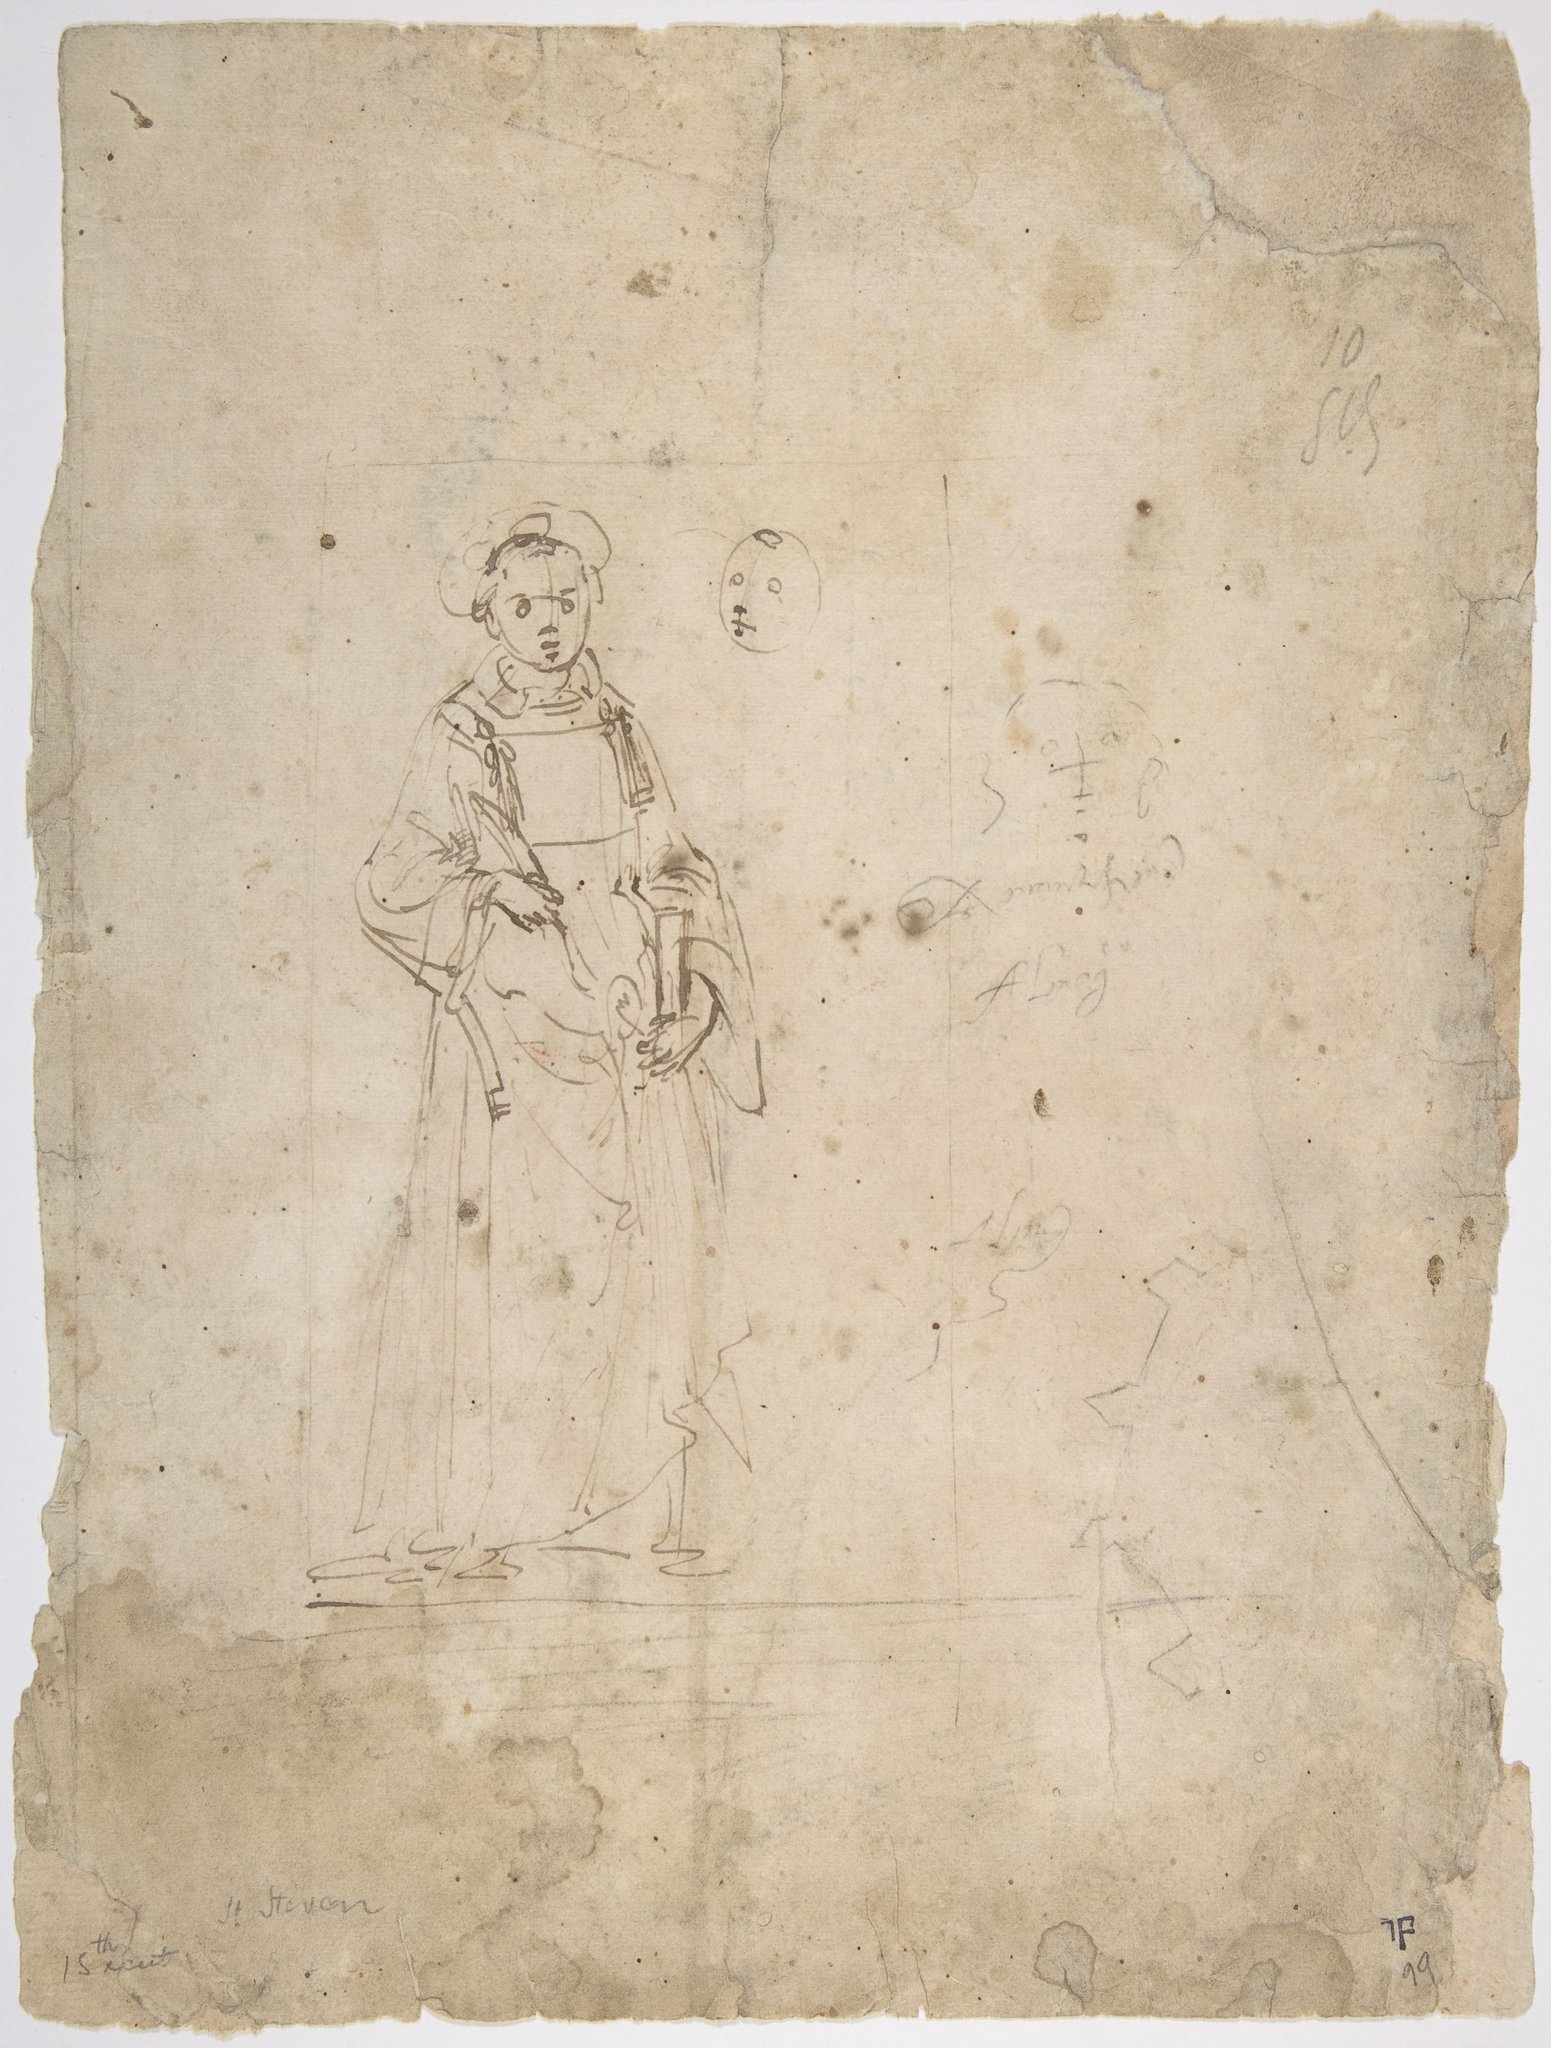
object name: drawing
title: Standing Figure of Saint Stephen and the Head of Another Figure Within the Framing Outlines of a Rectangle, Crude Sketch of the Head of Another Figure, Undecipherable Sketch of a Polygonal or Circular Object with Small Projections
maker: domenico ghirlandaio (domenico bigordi)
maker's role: artist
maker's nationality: italian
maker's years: 1448-1494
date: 1492-1494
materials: chalk, ink, drawing material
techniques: pen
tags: saints